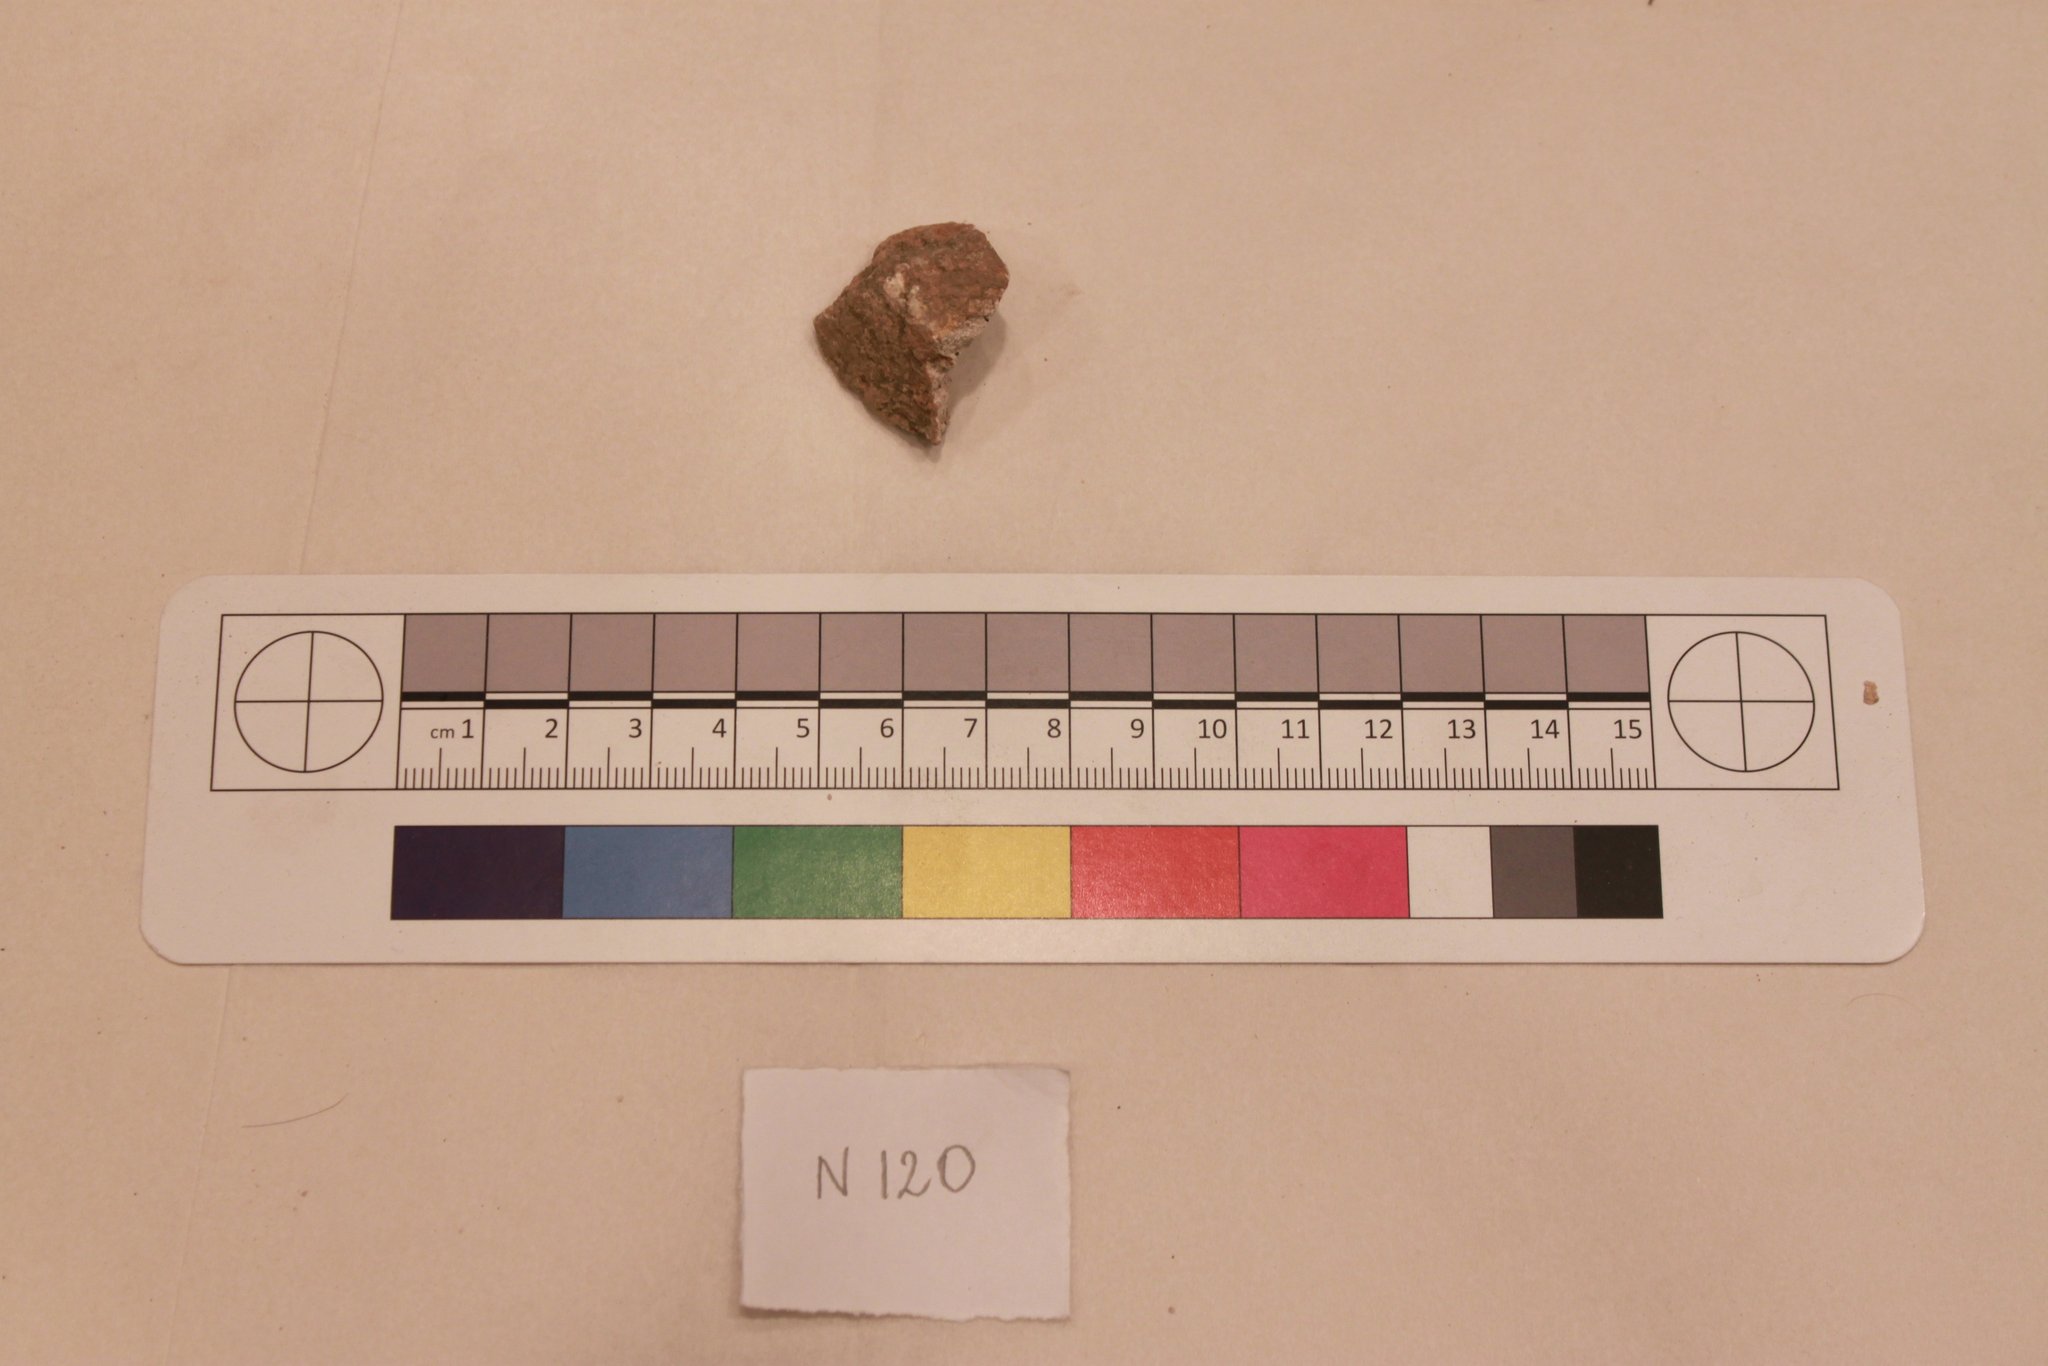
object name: fragment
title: Stucco Fragment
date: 701-1200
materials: plaster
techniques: painting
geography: iran